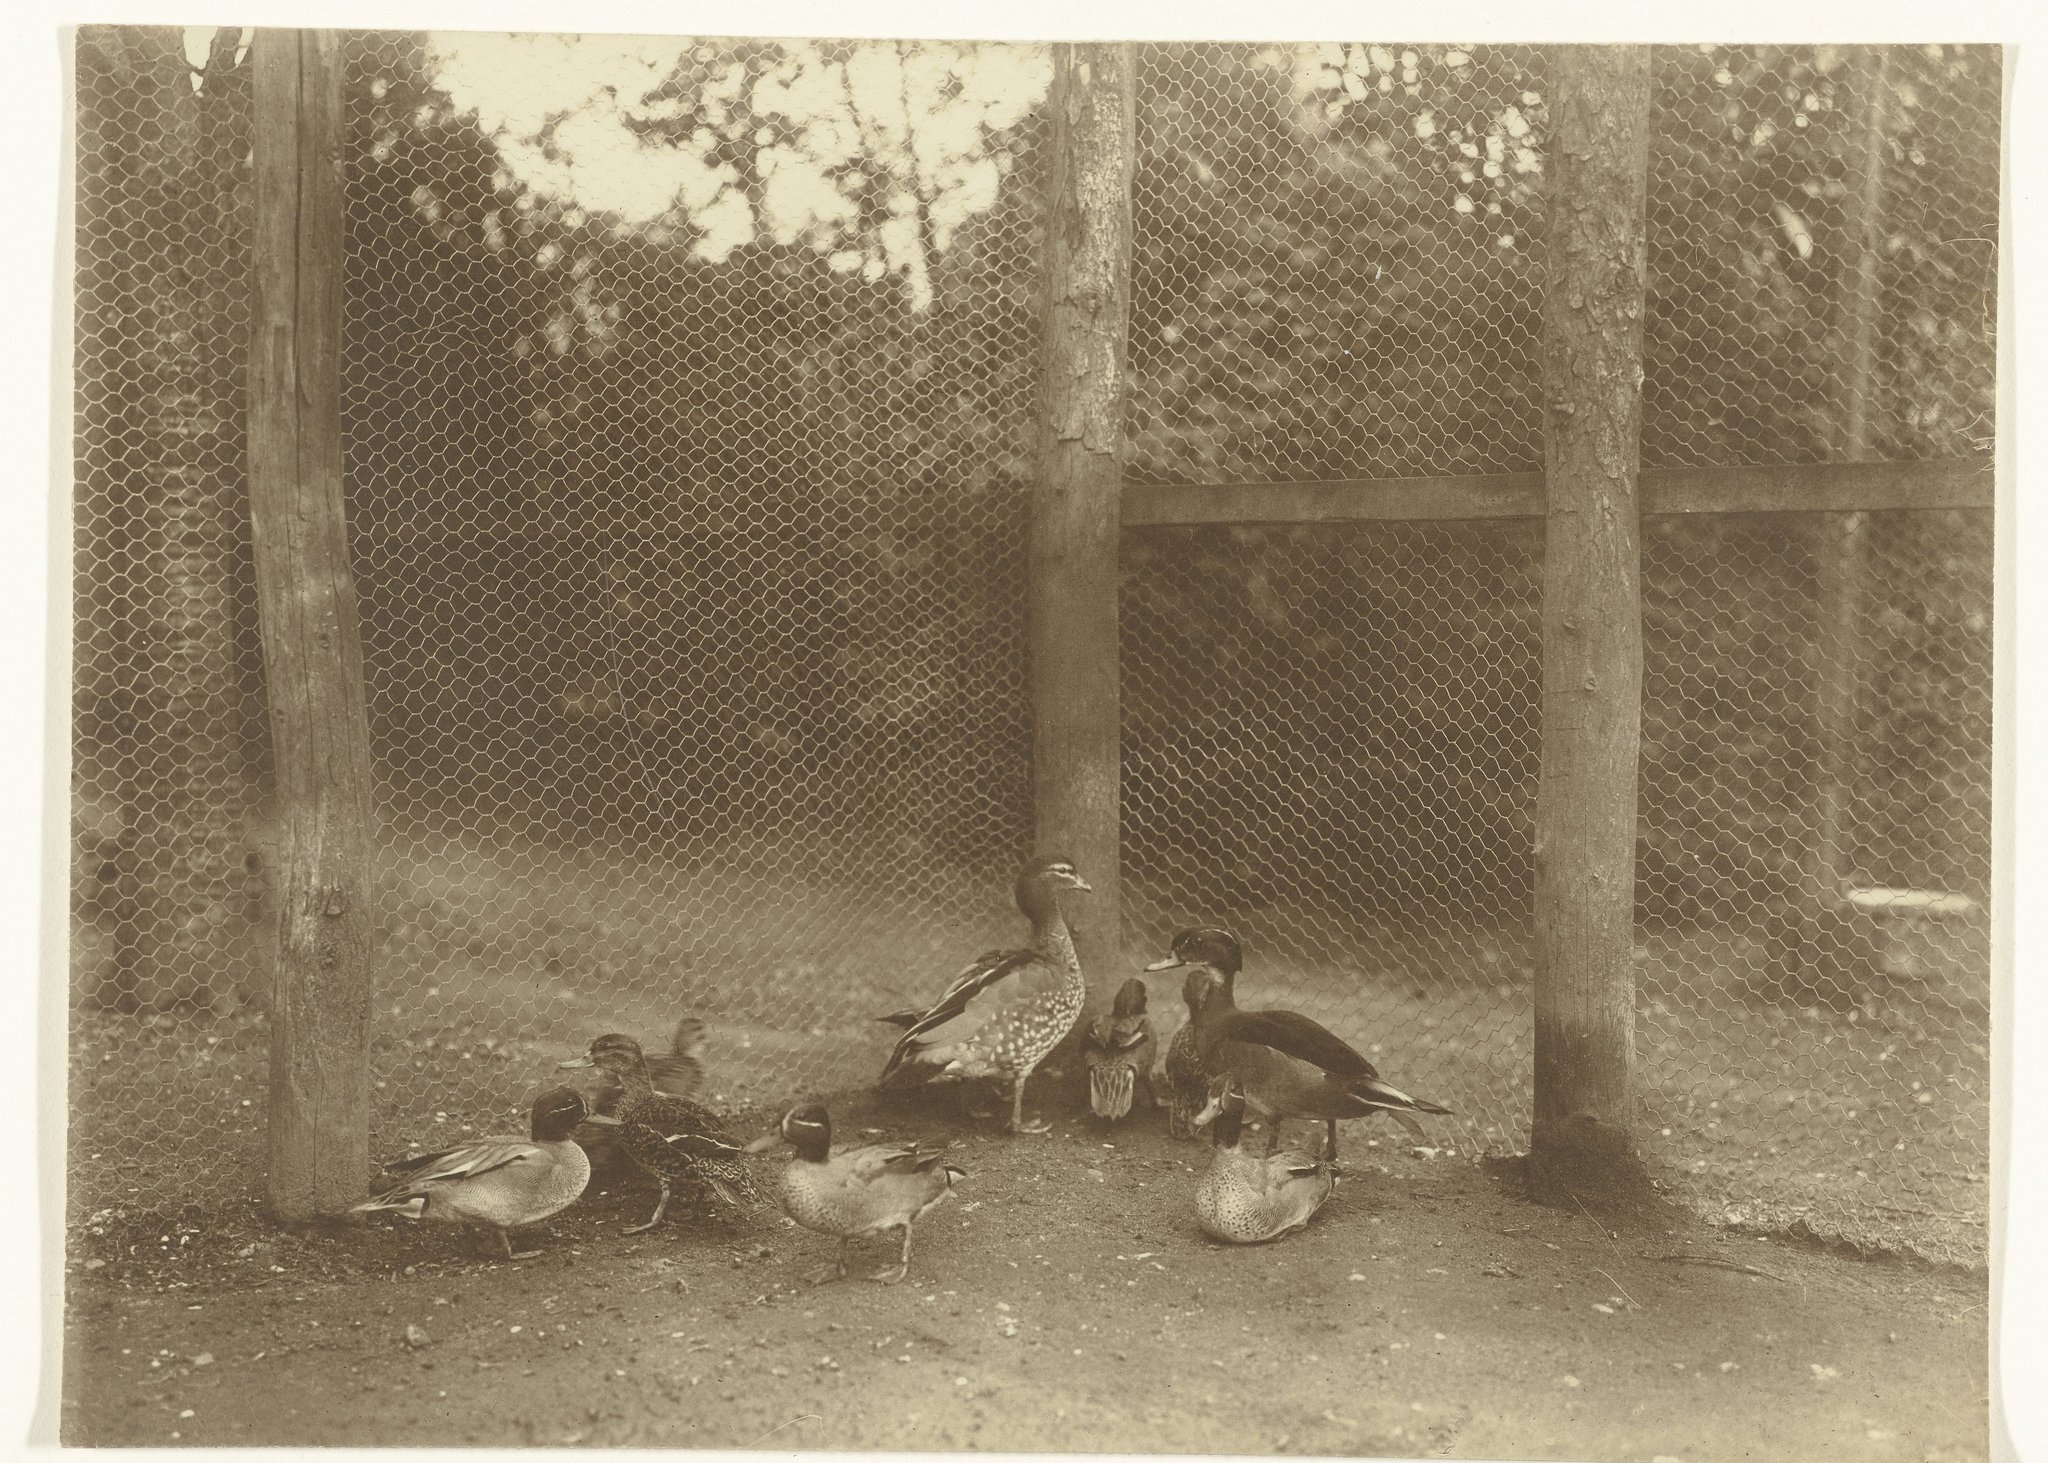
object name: photograph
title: Eenden in een hok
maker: richard tepe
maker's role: fotograaf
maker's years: 1864-1952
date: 1900-1930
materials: paper, photographic support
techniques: gelatin silver print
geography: netherlands